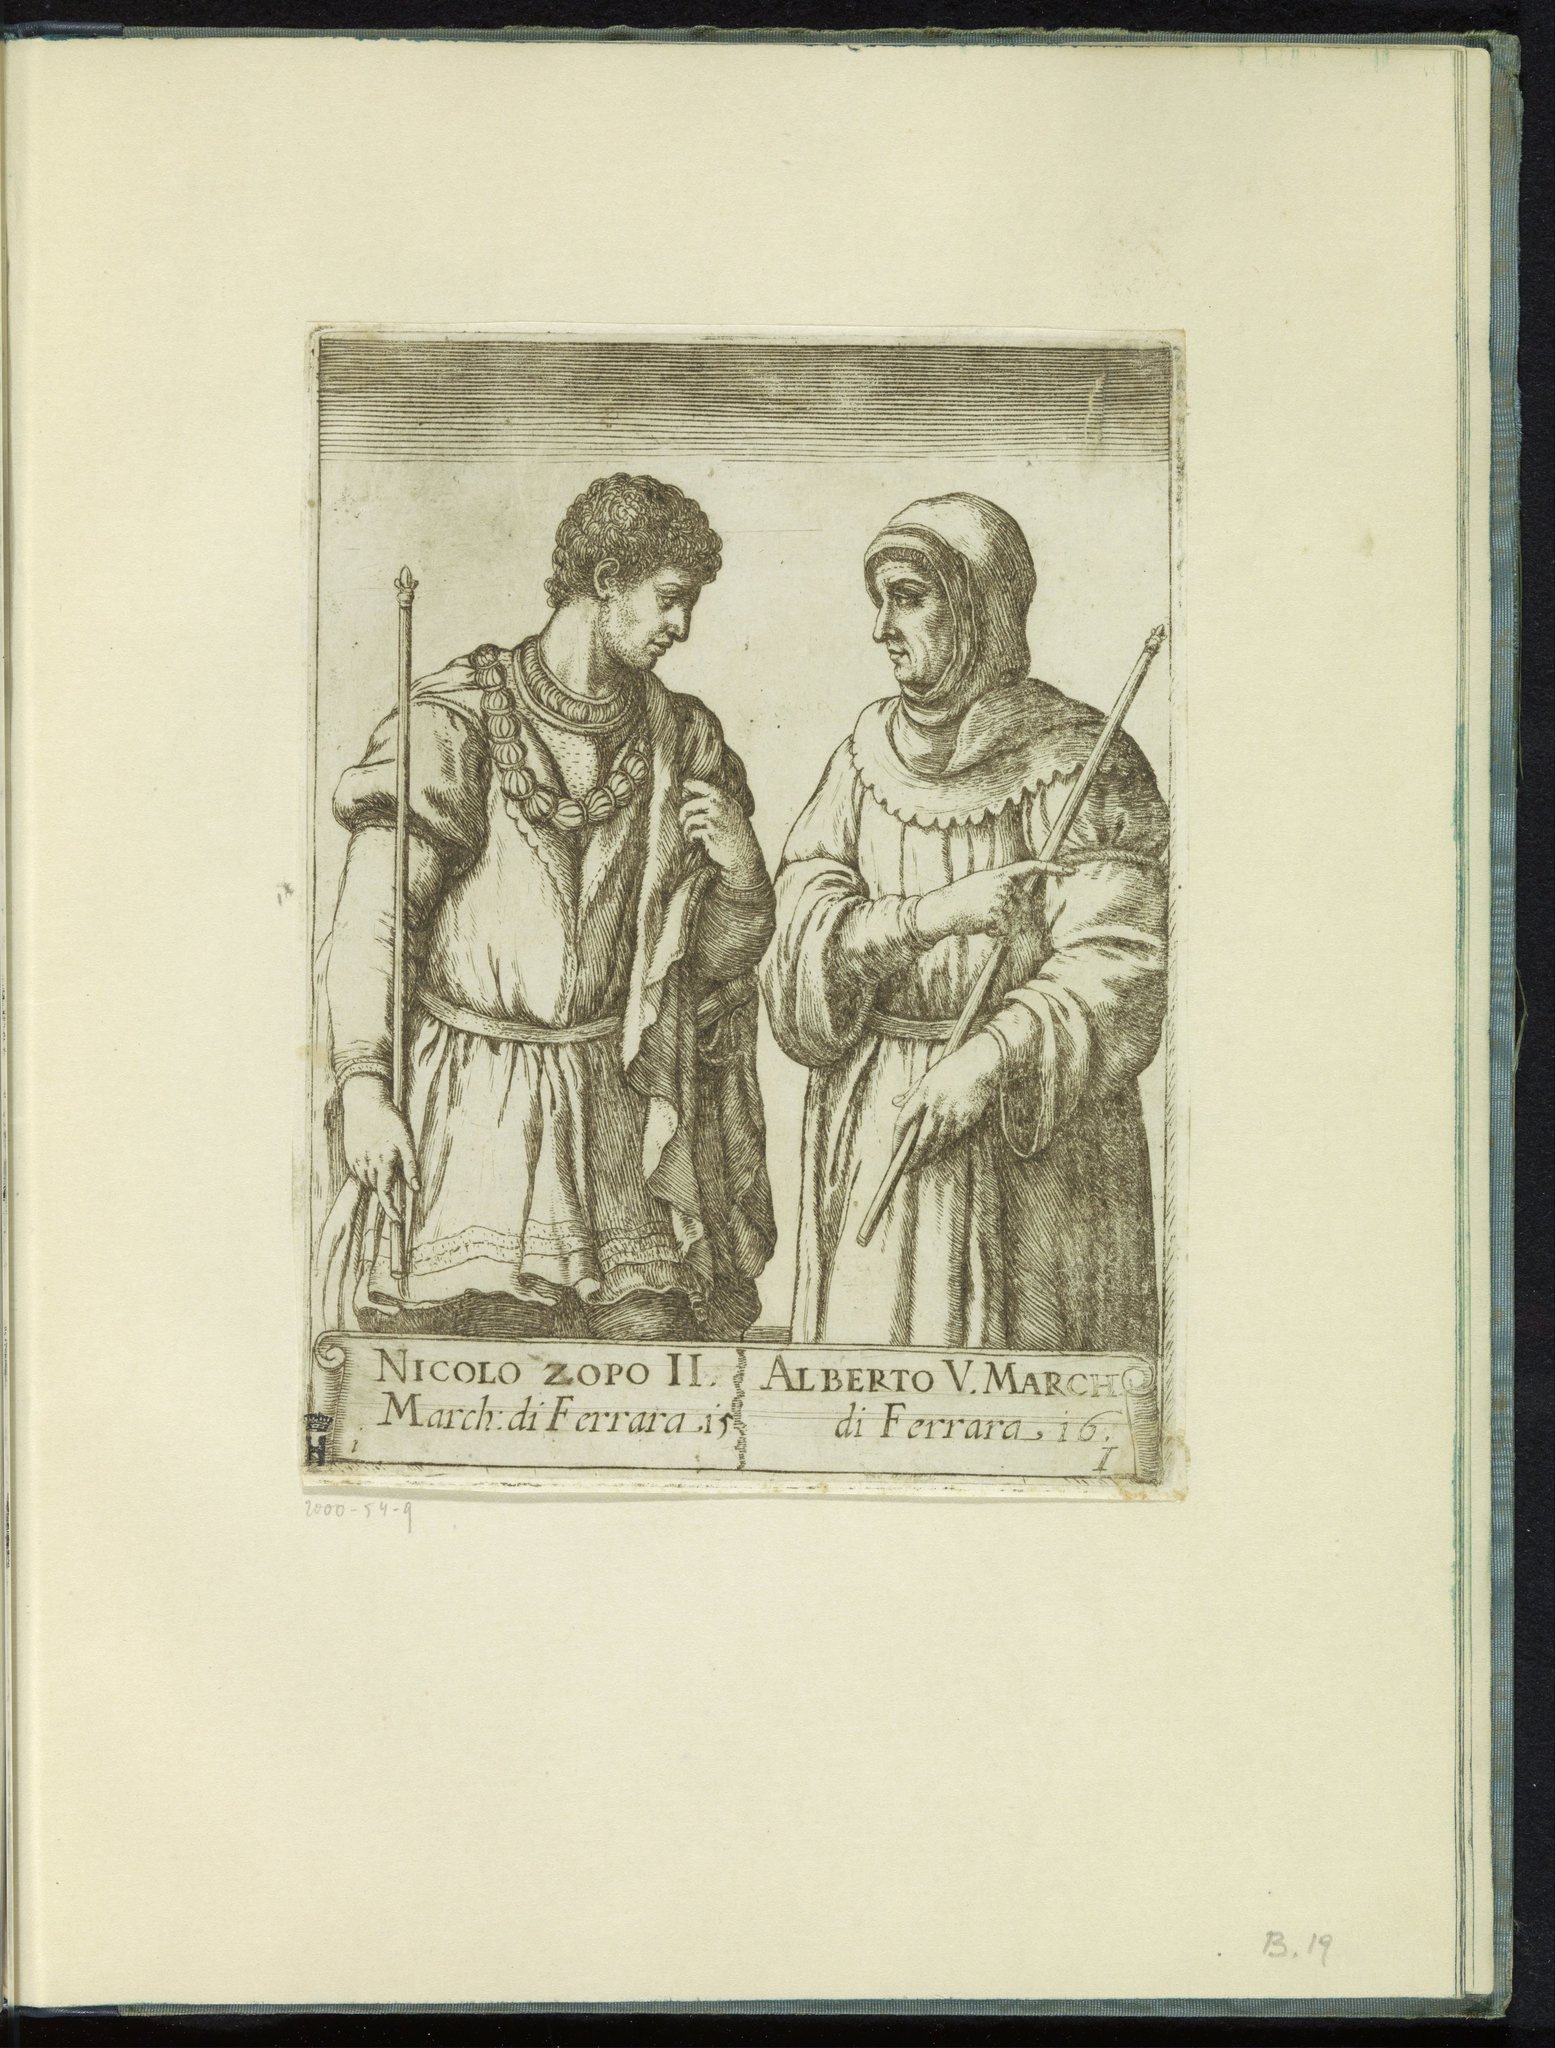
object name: print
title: Nicolo Zopo II. March: di Ferrara 15 i/ Alberto V. March. di Ferrara 16 I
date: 1641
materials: paper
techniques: etching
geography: italy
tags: historical persons, ruler, sovereign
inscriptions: collector's mark: Lugt 1282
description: Prent gebruikt voor Antonio Cariola. Ritratti De' Ser.mi Principi d'Este Sig.ri di Ferrara, Ferrara: Francesco Suzzi, 1641.